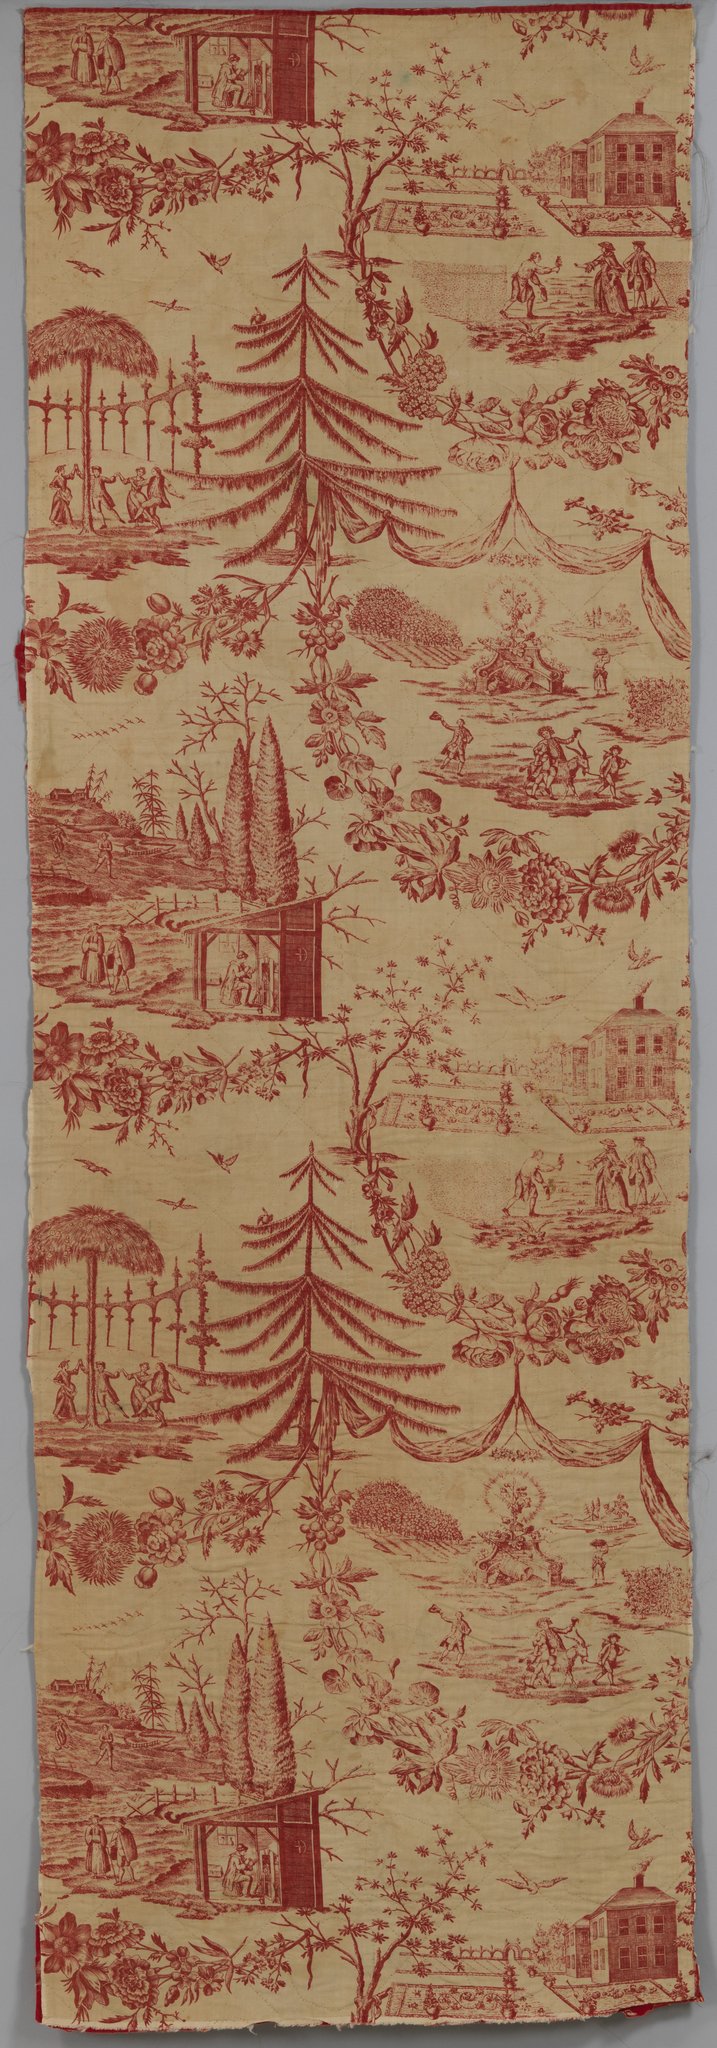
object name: panel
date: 1776-1800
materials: cotton, wool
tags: human figures,buildings,garlands,flowers